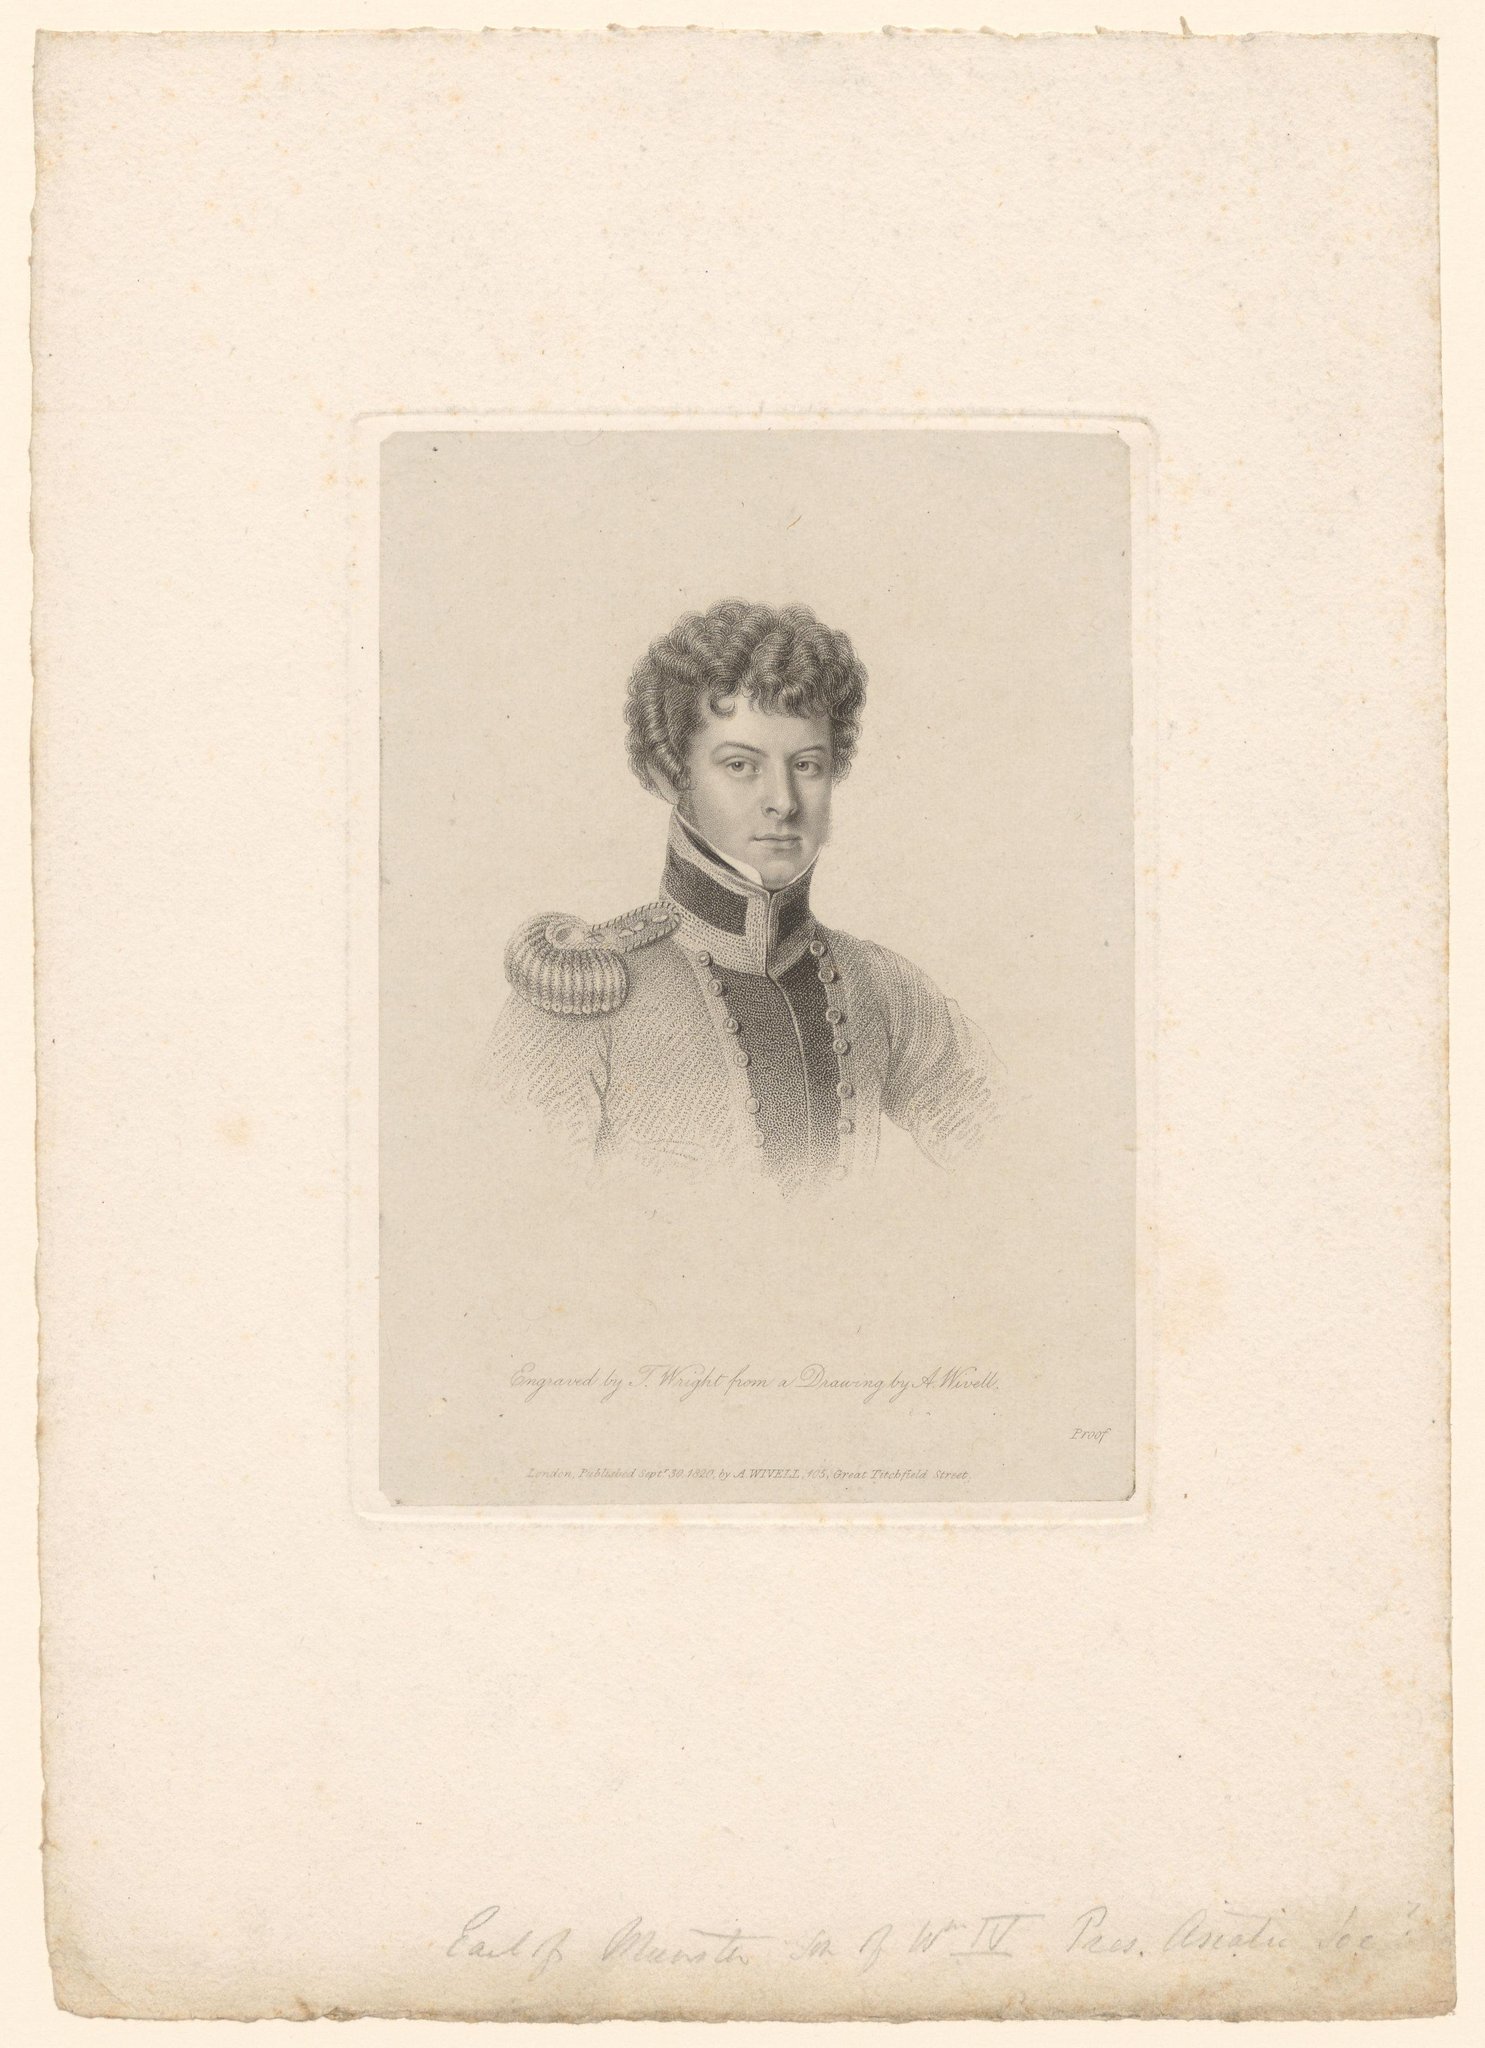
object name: print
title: Portret van George FitzClarence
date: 1820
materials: paper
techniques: etching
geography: london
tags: commander-in-chief, general, marshal, historical persons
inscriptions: collector's mark: Lugt 2228